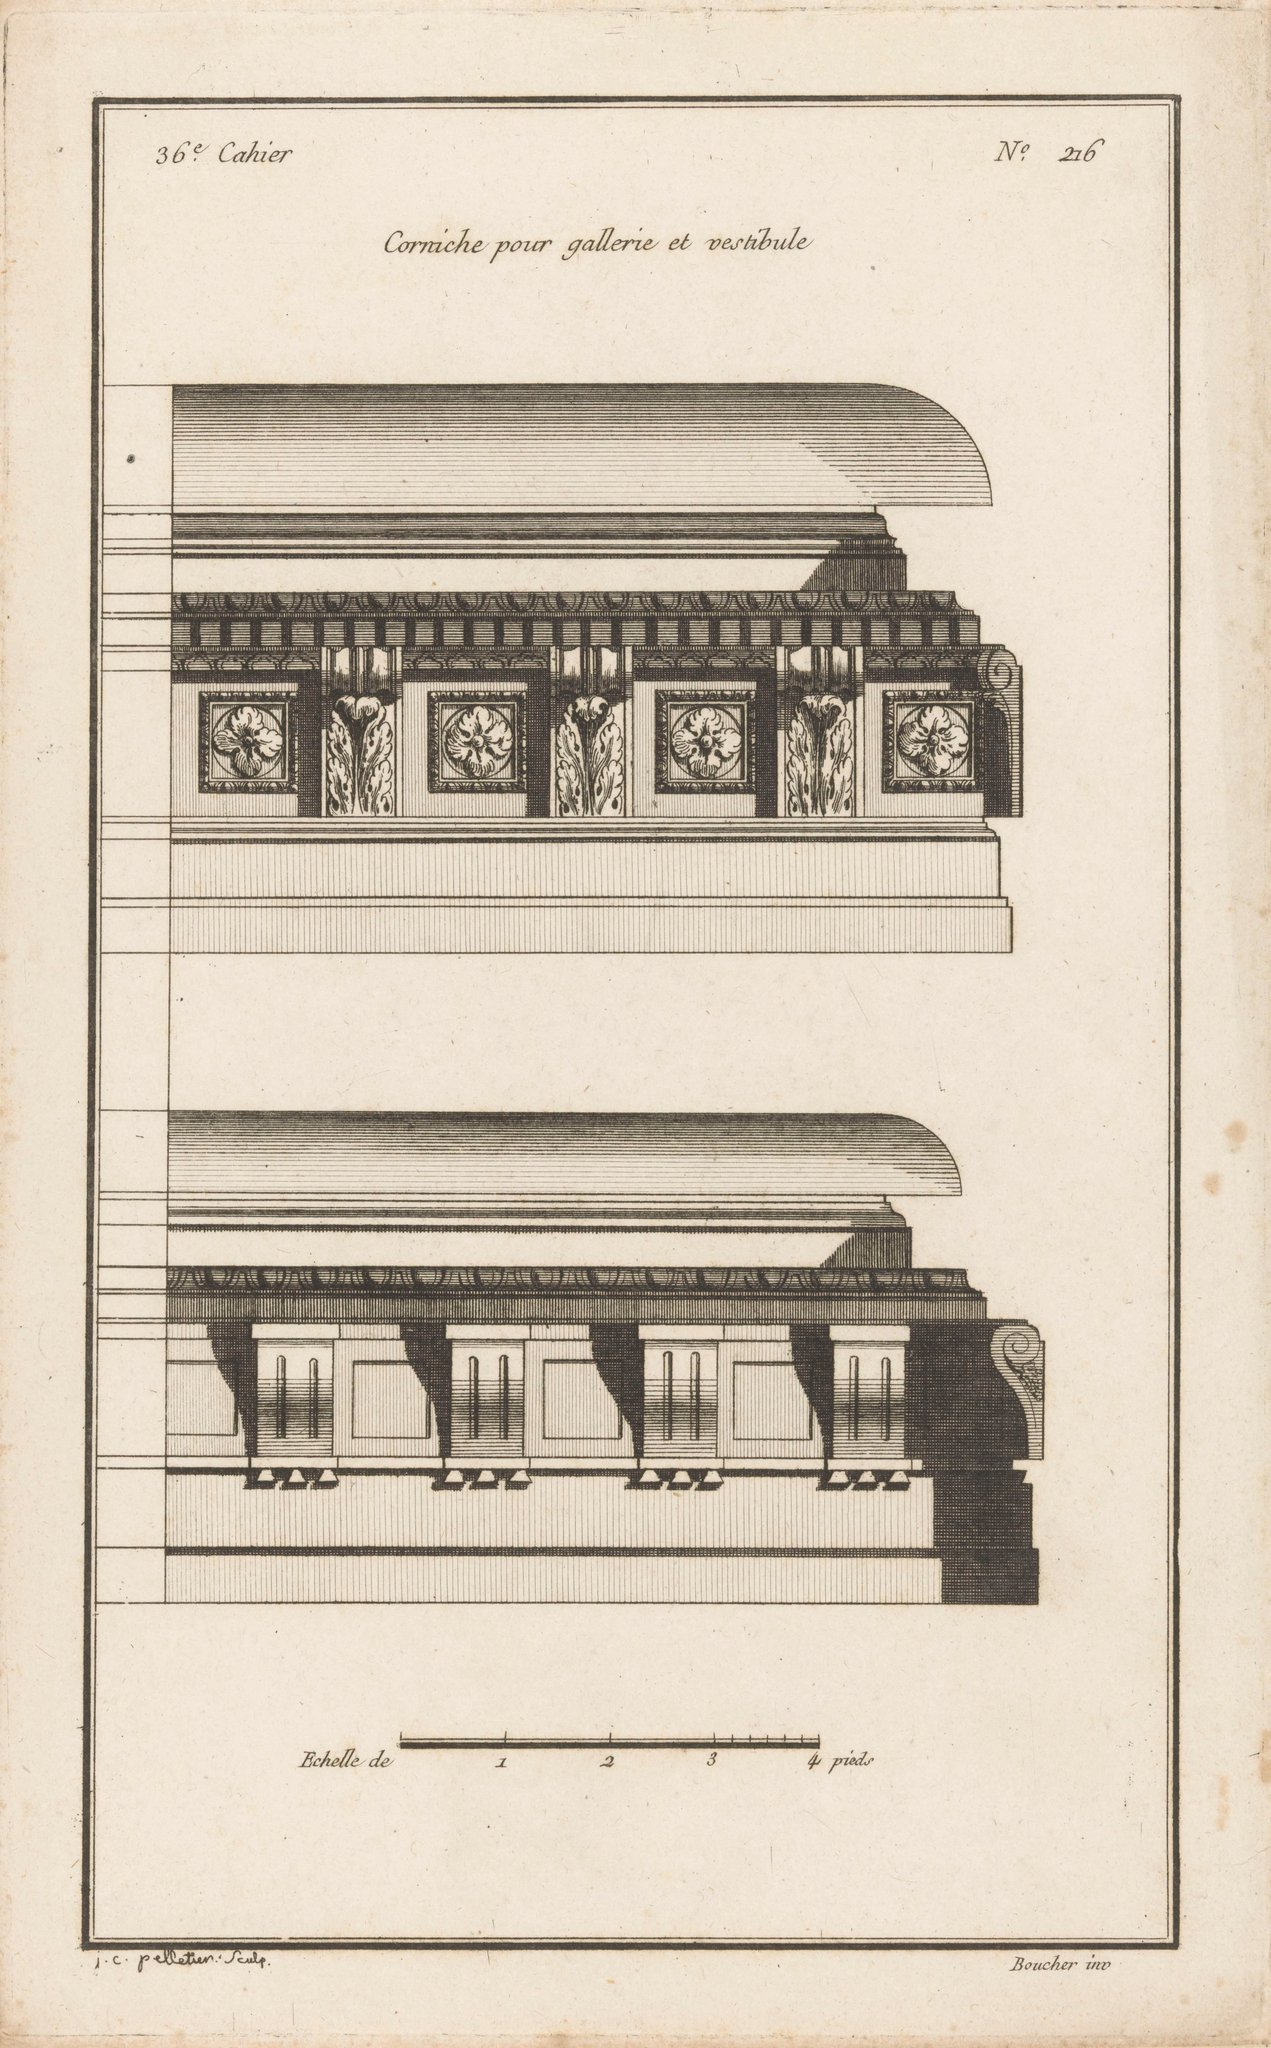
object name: ornament print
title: Corniche pour gallerie et vestibule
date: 1772-1779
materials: paper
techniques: engraving, etching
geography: paris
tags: other architectural details (cornice)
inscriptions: collector's mark: Lugt 2228, collector's mark: Lugt 2760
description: Twee geornamenteerde kroonlijsten, de bovenste kroonlijst met bladmotieven. Prentnummer 216.